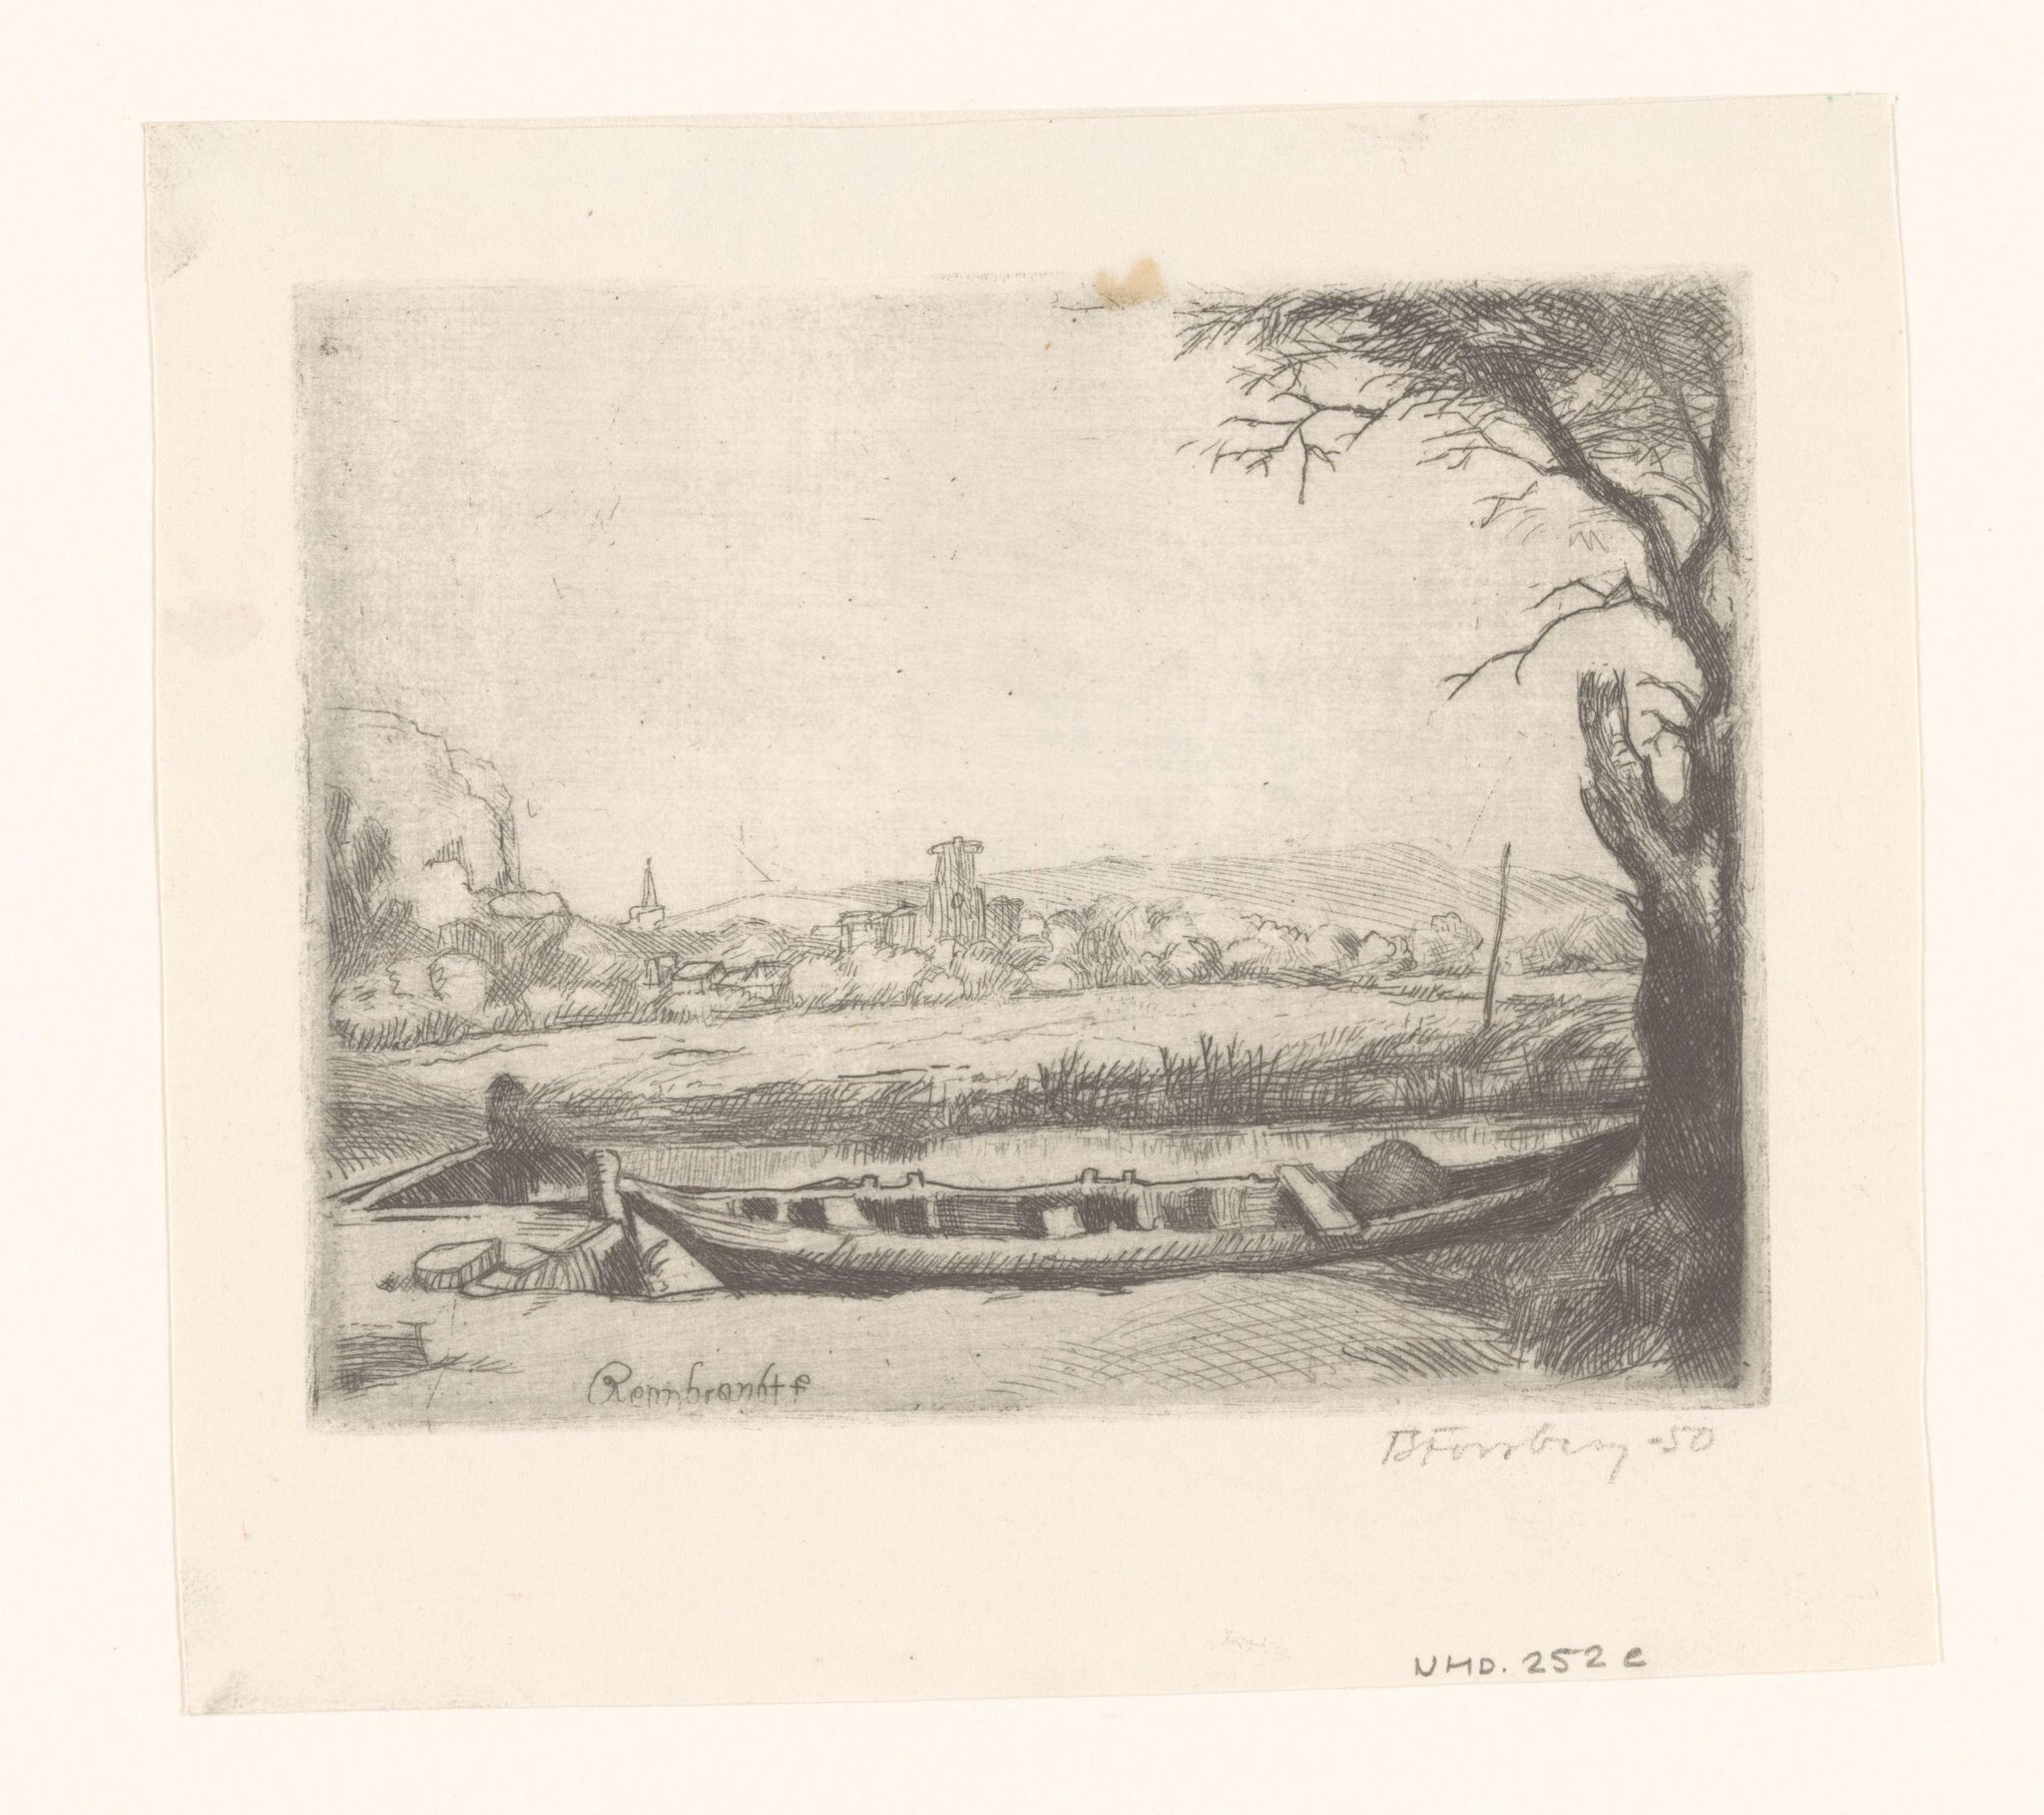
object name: print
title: Canal with a large boat and a bridge ('Het schuytje op de voorgrond')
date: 1923-1957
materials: paper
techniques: etching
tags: rowing-boat, canoe, etc.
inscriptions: collector's mark: Lugt 2228, collector's mark: Lugt 2760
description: Spiegelbeeldige kopie naar de gelijknamige prent van Rembrandt.